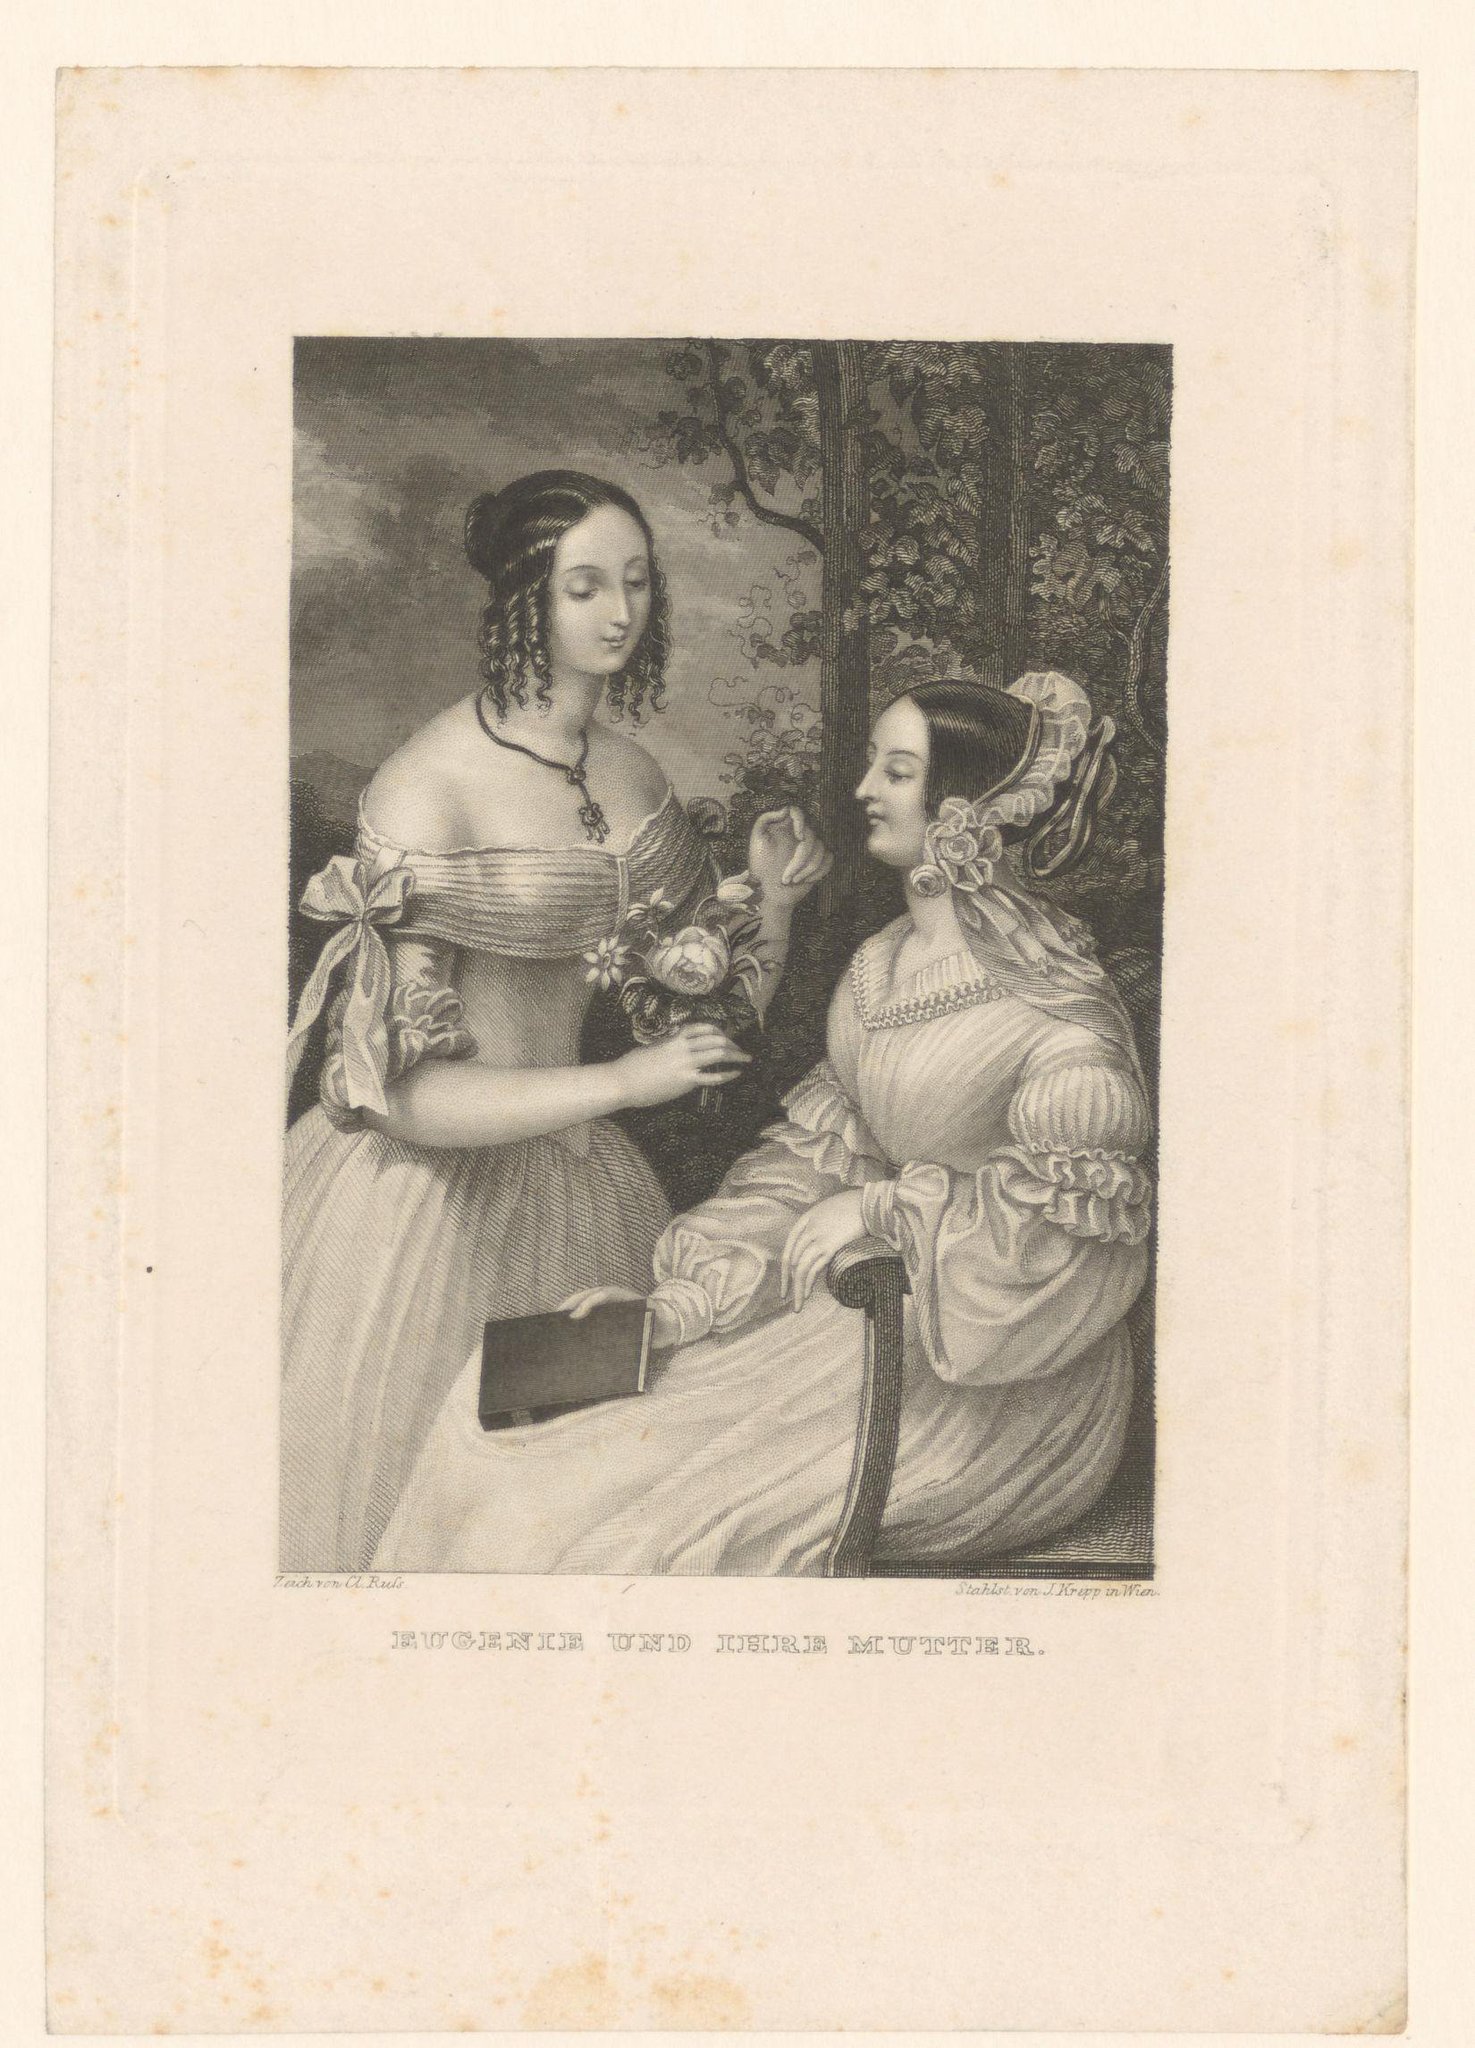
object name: print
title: Eugenie und ihre Mutter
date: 1811-1853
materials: paper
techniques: engraving, etching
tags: bourgeoisie, middle class, citizens, burghers, bringing gifts; exchanging gifts, fashionable woman, 'belle'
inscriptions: collector's mark: Lugt 2228